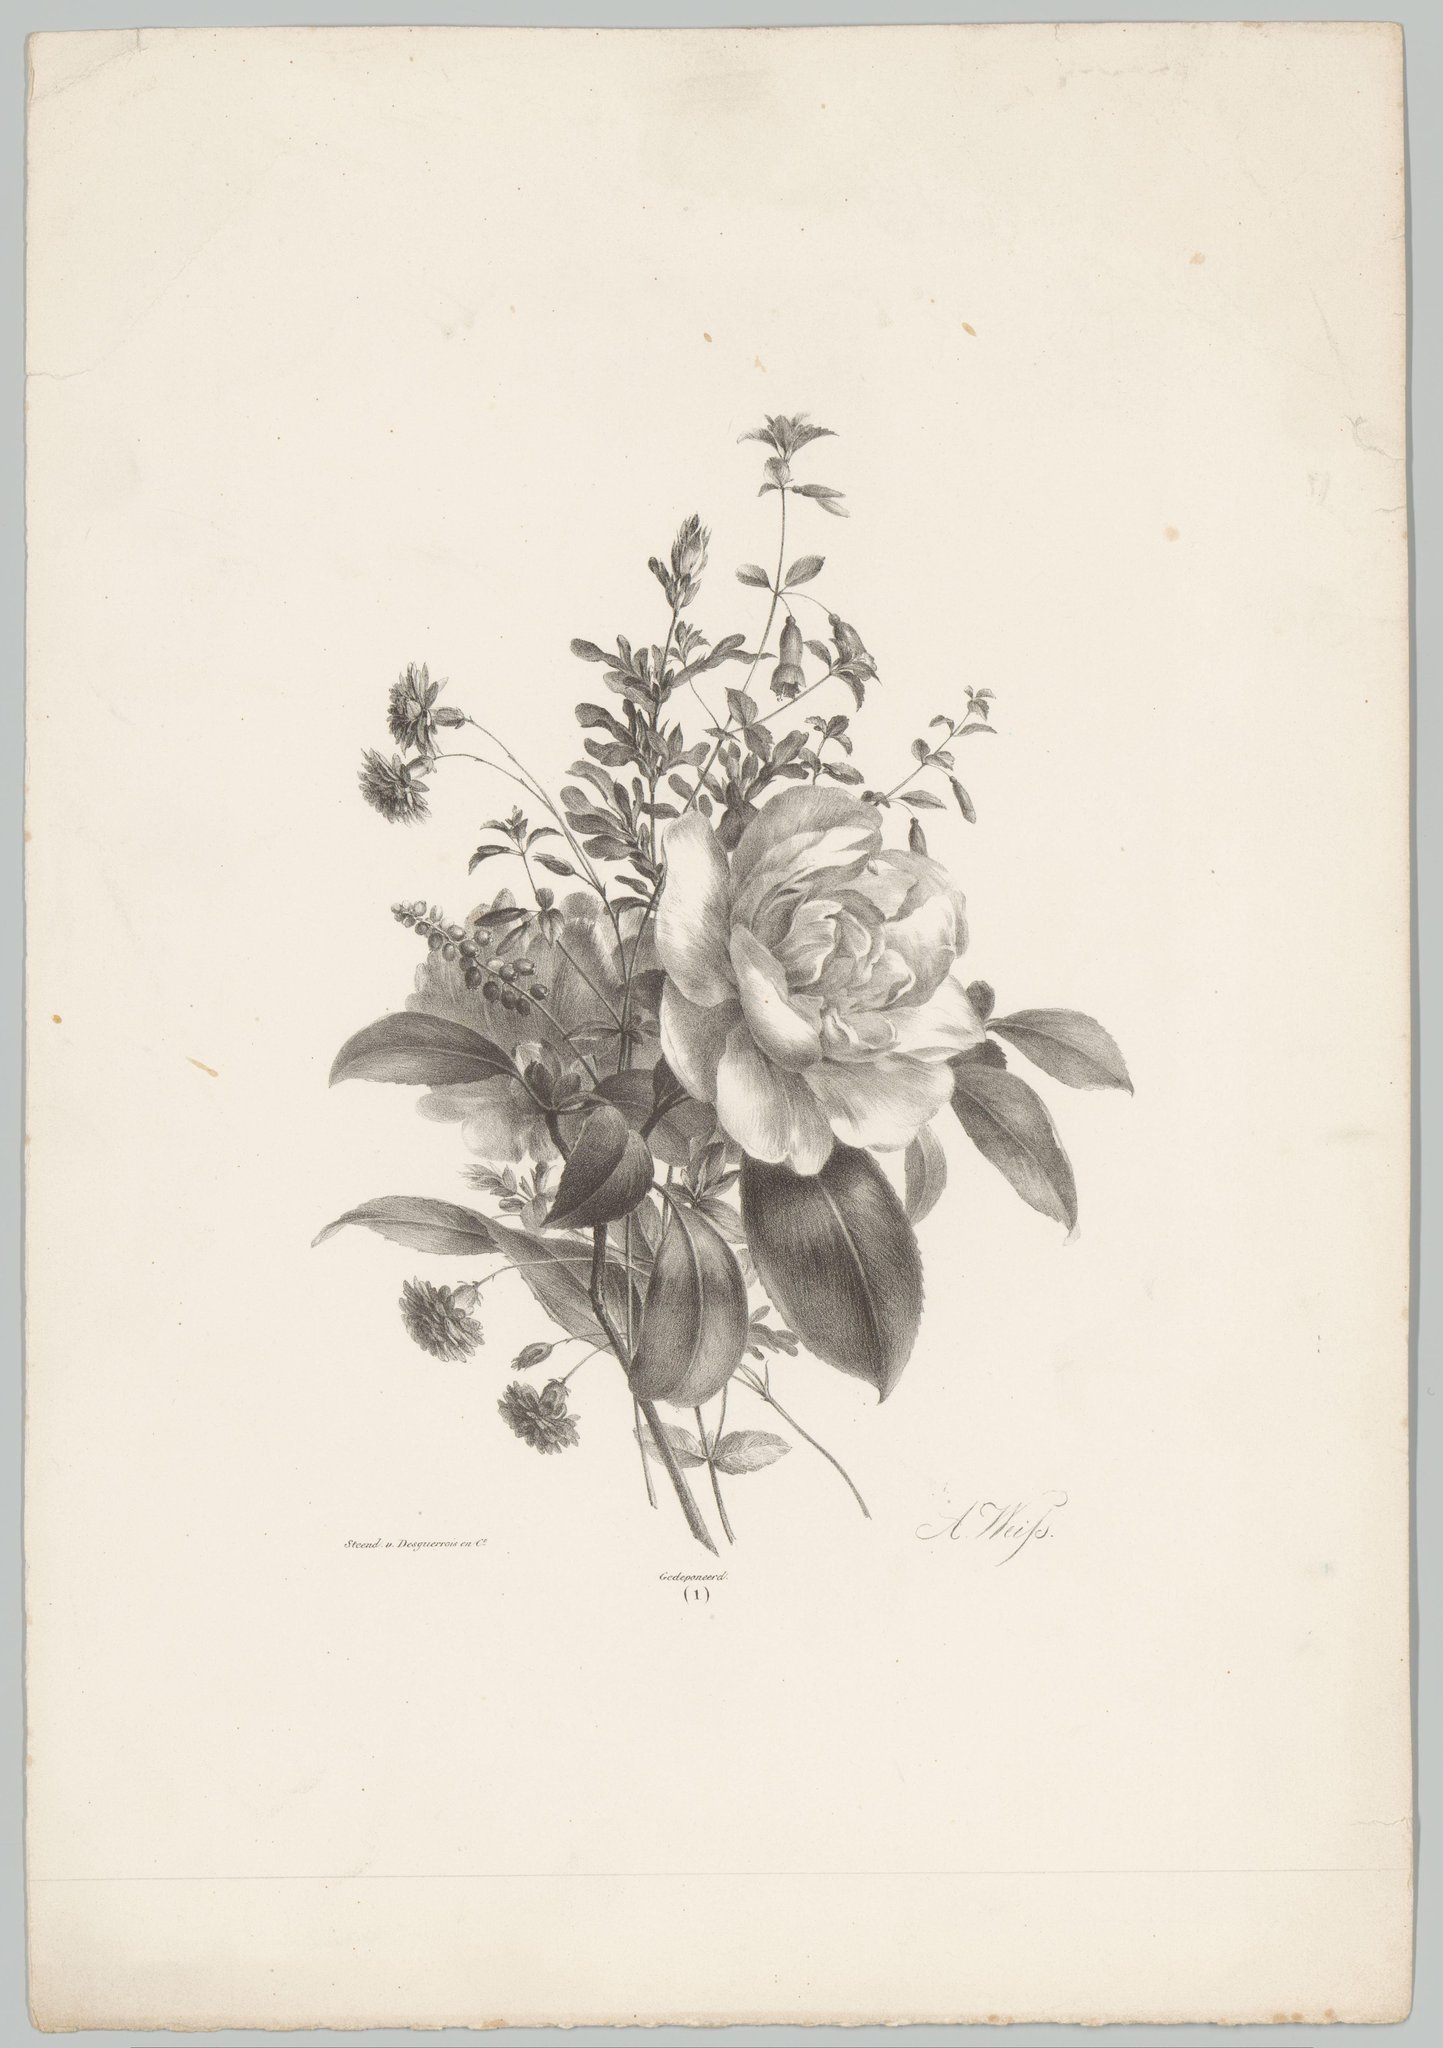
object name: print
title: Bloem en Fruit Studien (...) 10e aflevering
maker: anton weiss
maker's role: draughtsman, print maker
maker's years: 1801-1851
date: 1836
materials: paper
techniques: lithograph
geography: amsterdam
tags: flowers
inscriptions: collector's mark: Lugt 2228, : ‘Gedeponeerd.’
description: Onderdeel van een omslag met een serie van eenenveertig lithografieën van bloemen en fruit.